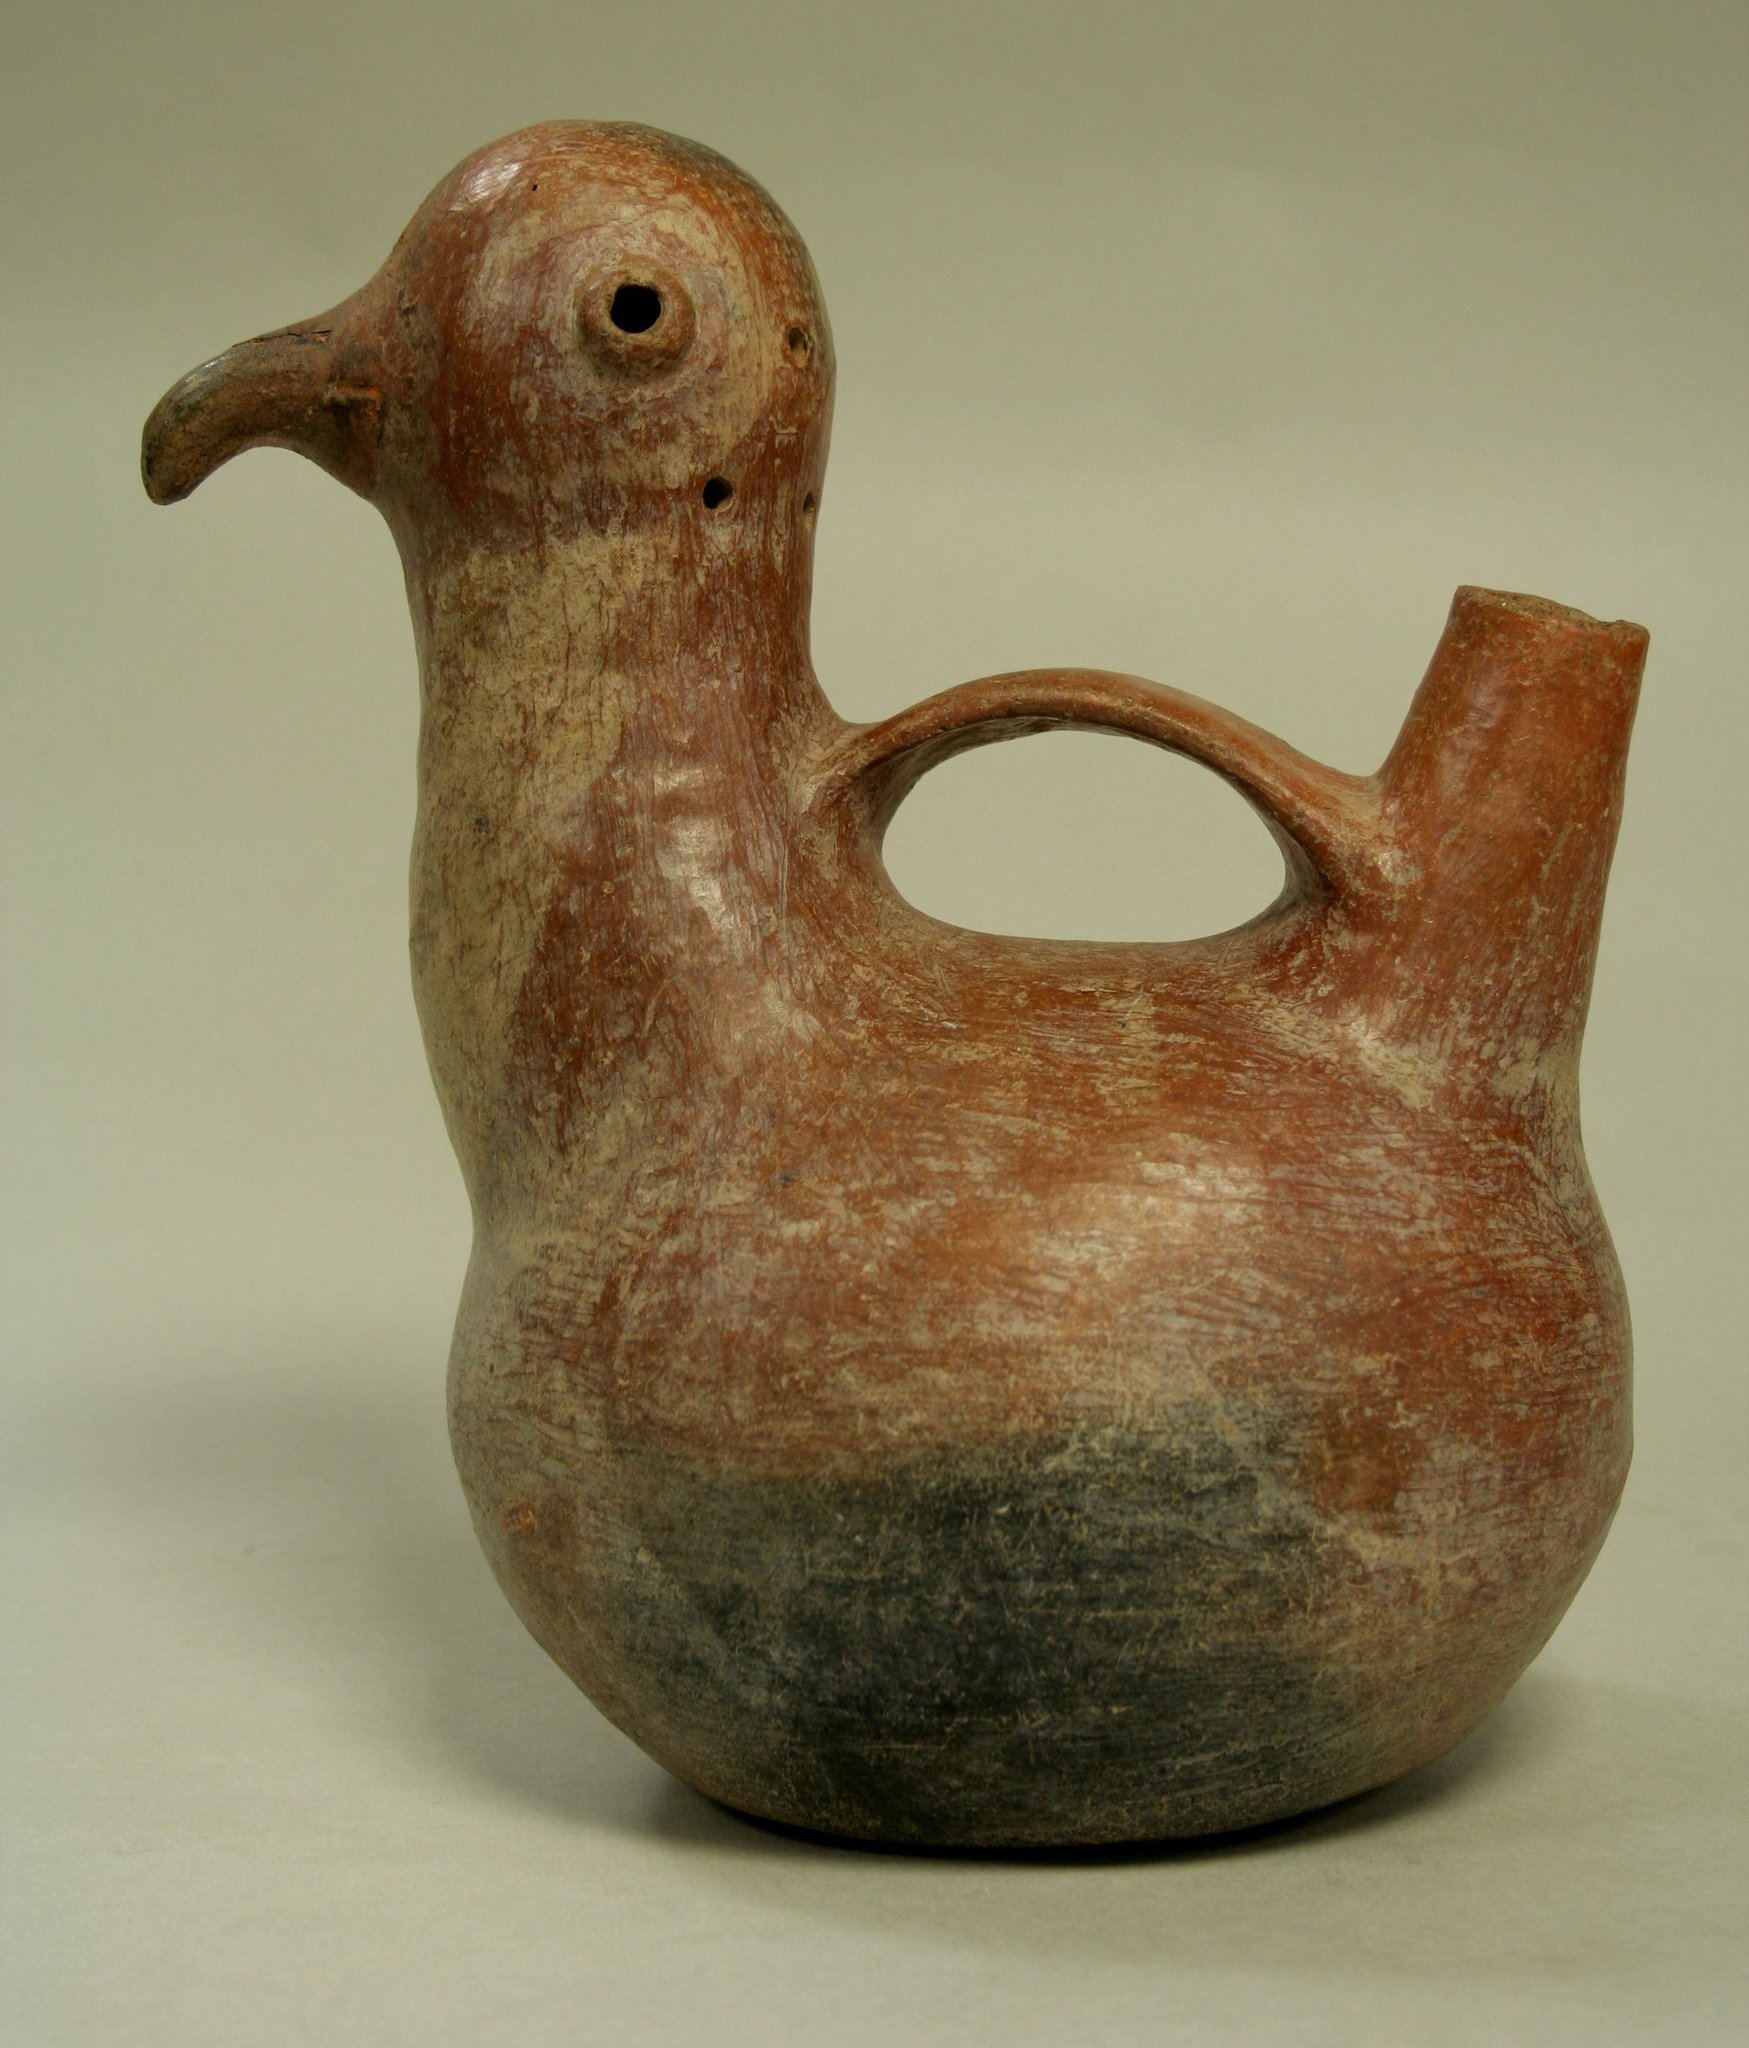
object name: bottle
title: Bridge and Spout Bottle in Bird Form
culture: vicús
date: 1-500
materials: ceramic, pigment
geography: peru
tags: birds